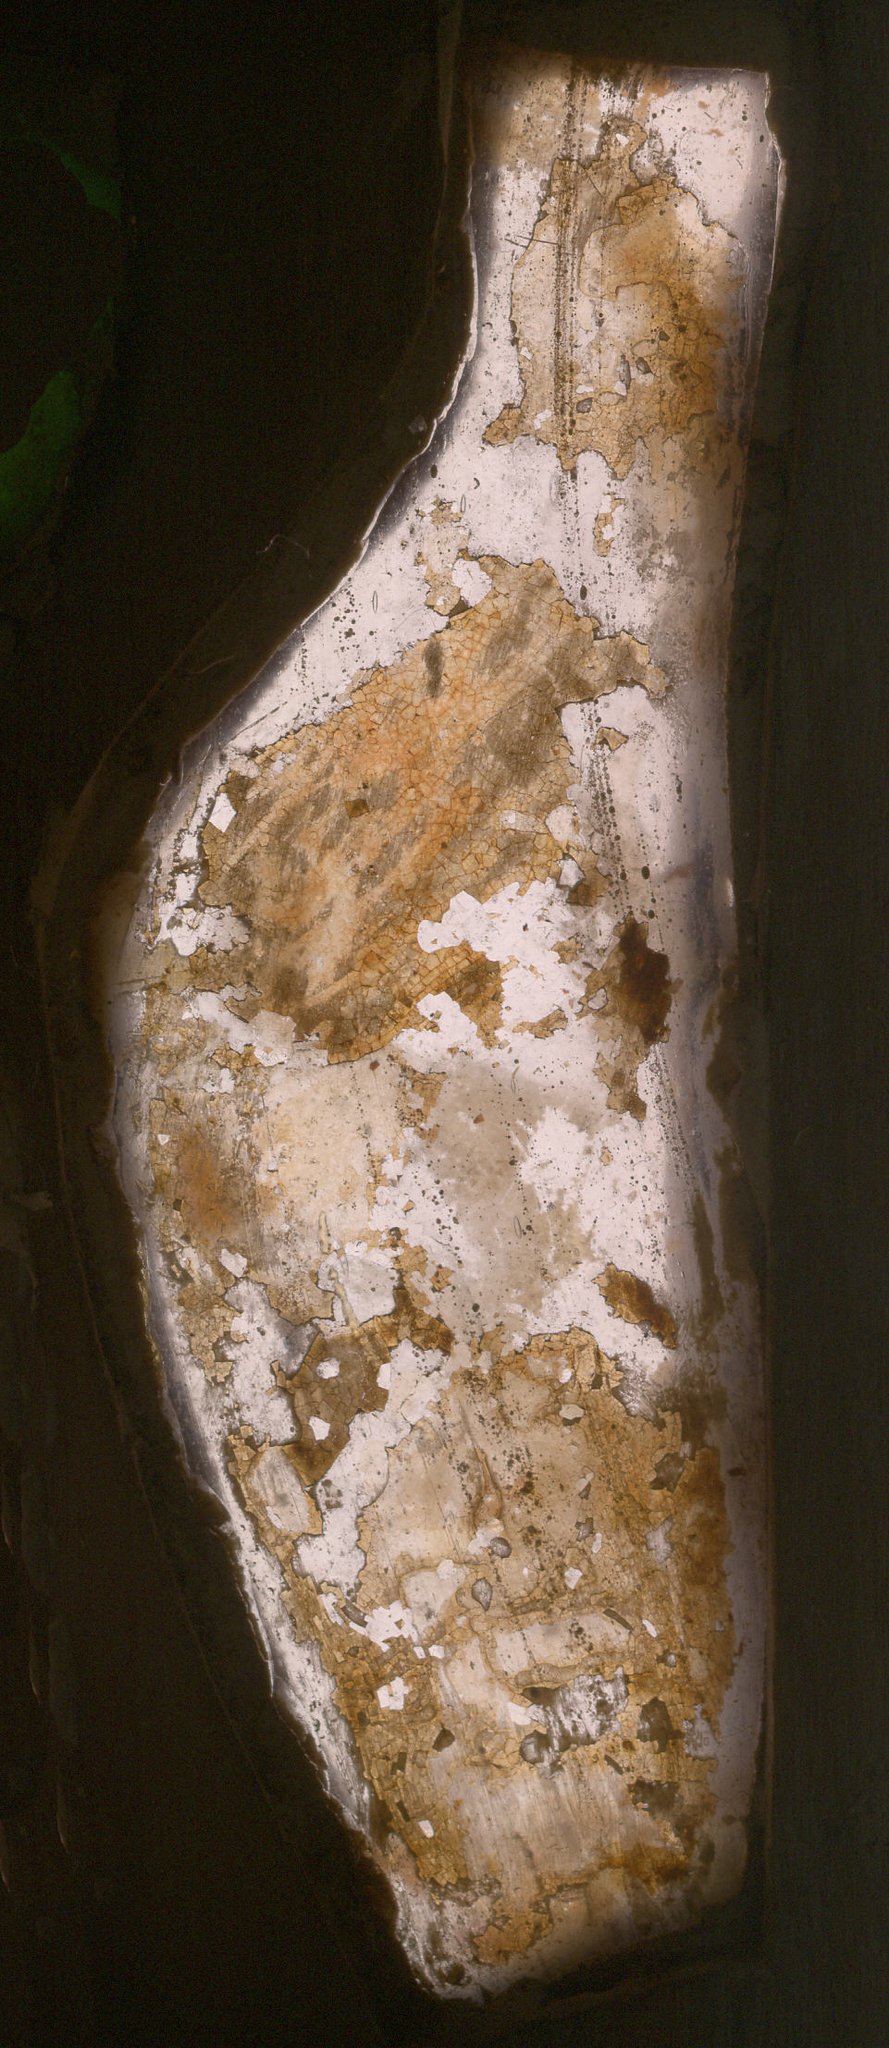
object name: fragment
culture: crusader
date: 1201-1300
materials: glass